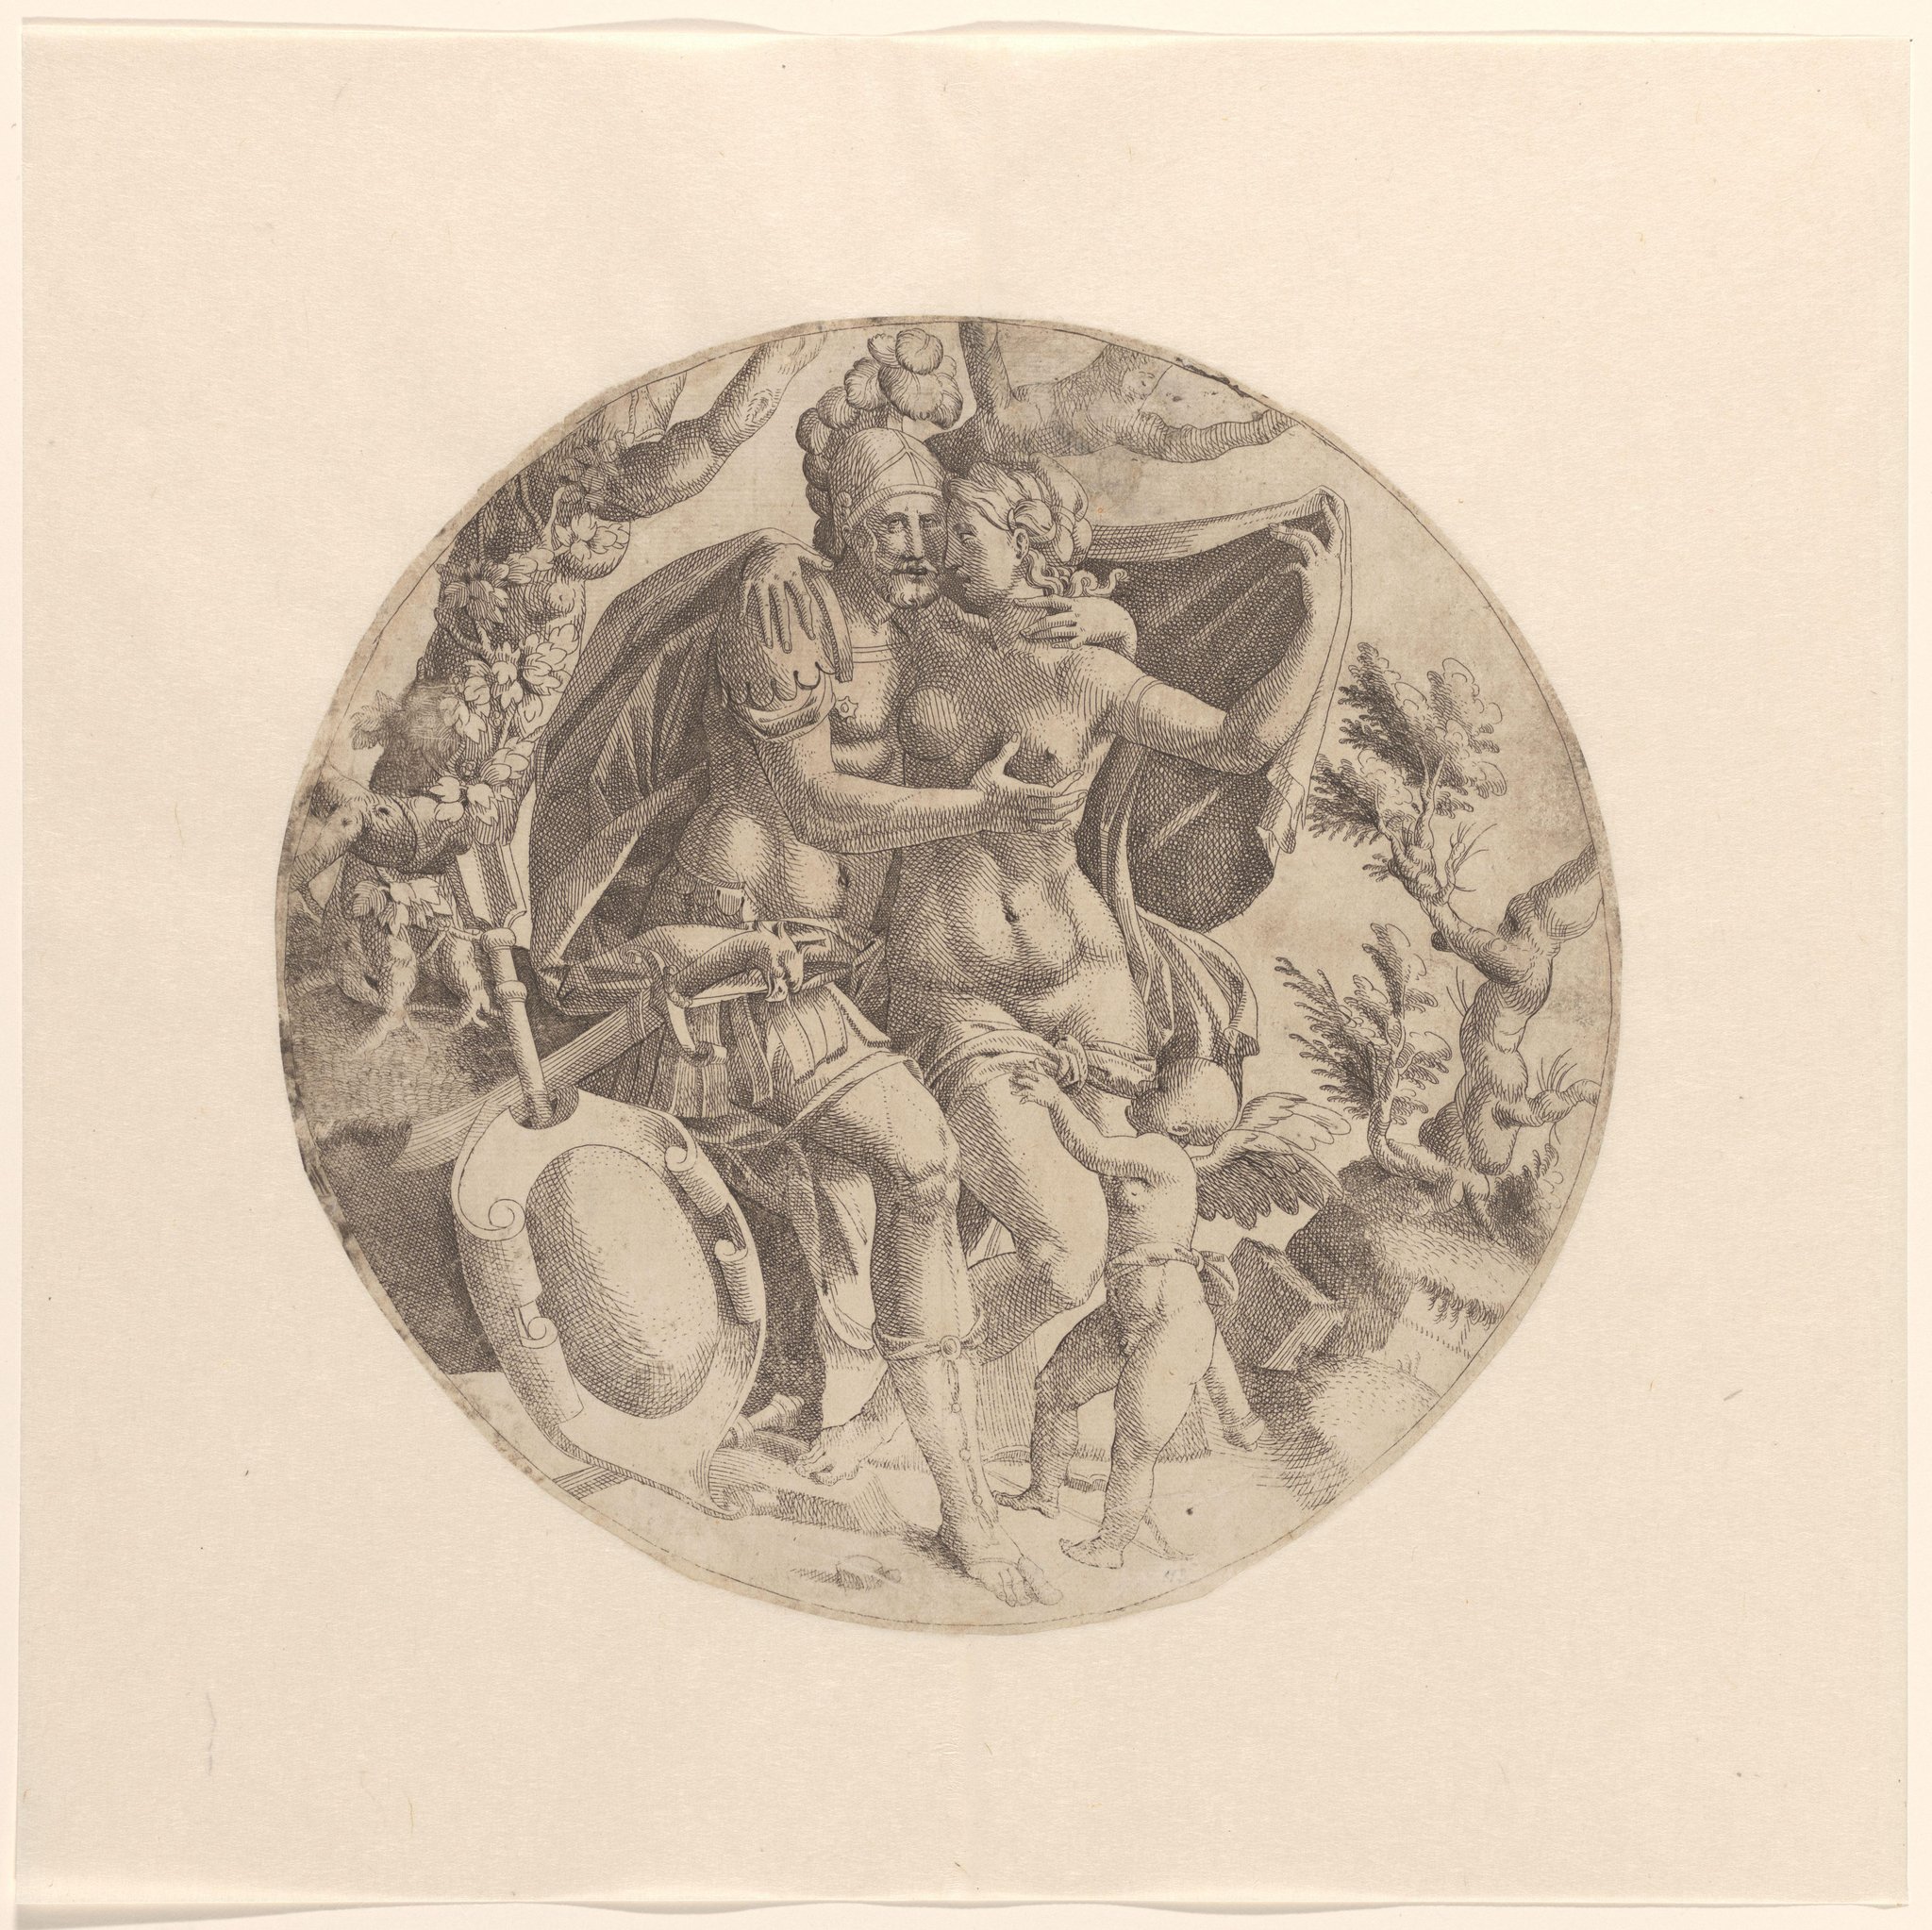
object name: print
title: Mars, Venus and Cupid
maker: jean mignon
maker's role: print maker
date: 1543-1545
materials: paper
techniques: etching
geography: fontainebleau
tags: mars and venus as lovers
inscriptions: collector's mark: Lugt 2228, collector's mark: Lugt 2760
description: In the early 1540s Jean Mignon worked as a painter in the palace of the French king in Fontainebleau. He also made etchings there, mostly after drawings by the Italian artist Luca Penni. Here he depicts a classical subject: Mars lovingly embracing Venus. Remarkably, in this interpretation Mars looks straight at us while caressing Venus’ bosom.